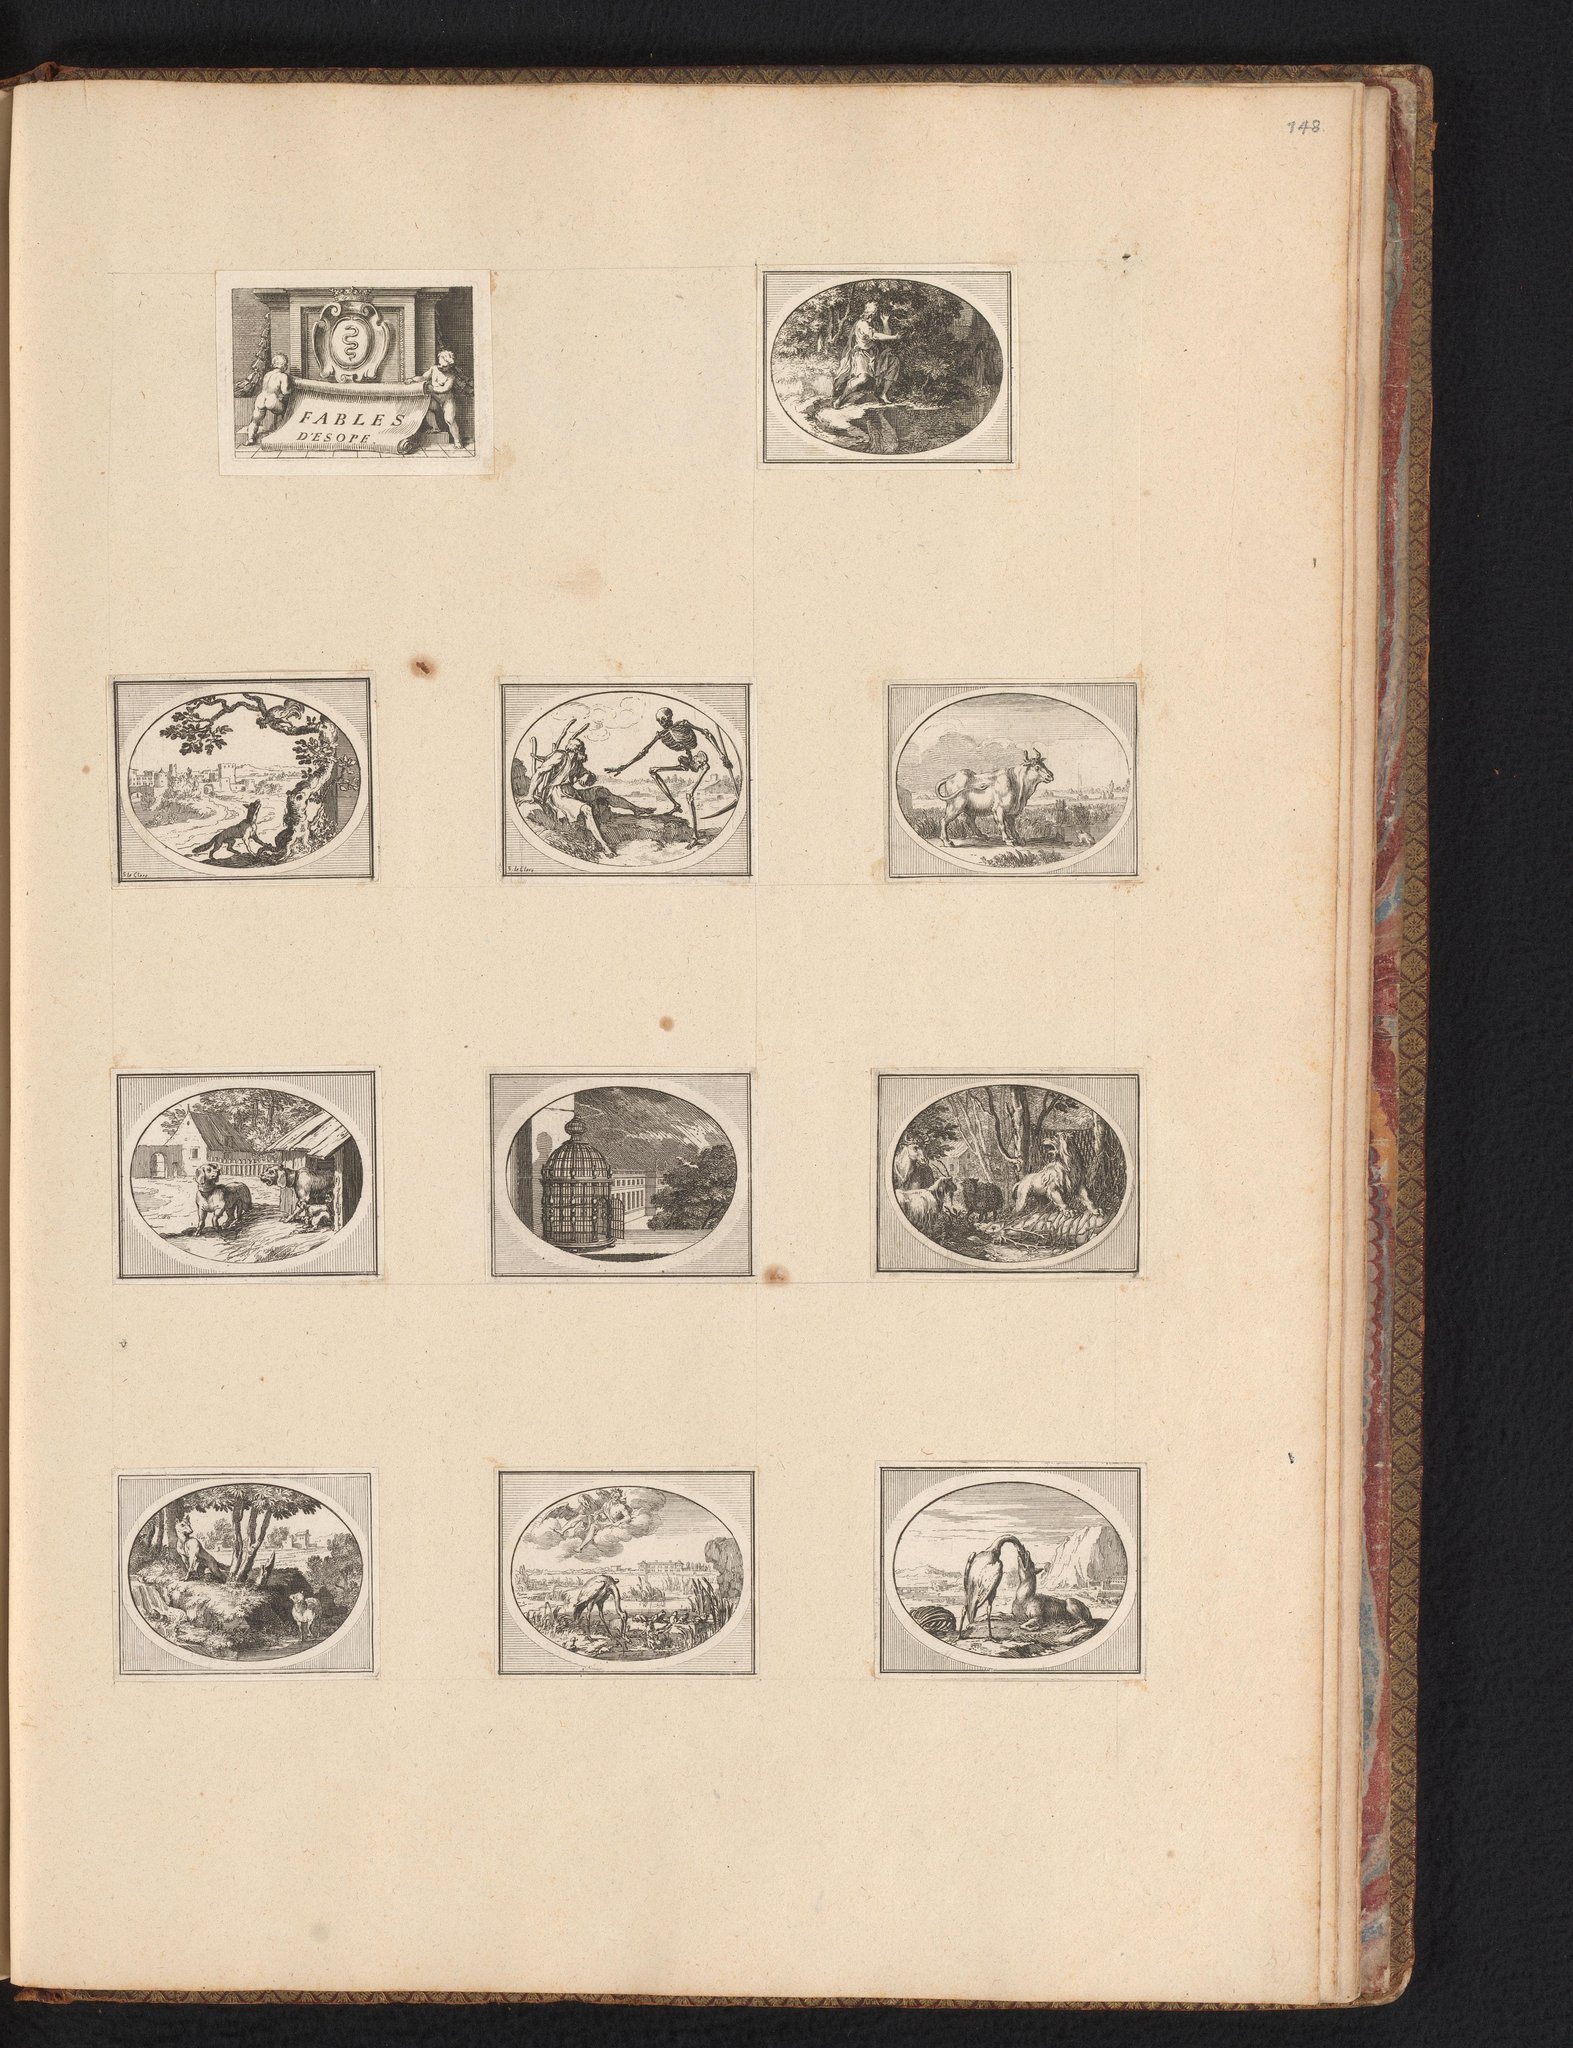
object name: print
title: Elf prenten uit de fabels van Aesopus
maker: sébastien leclerc (i)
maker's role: print maker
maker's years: 1637-1714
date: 1681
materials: paper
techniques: etching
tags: fables of aesop : use 85(...)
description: Deze elf prenten maken deel uit van een 22-delige serie met scènes uit de fabels van Aesopus.